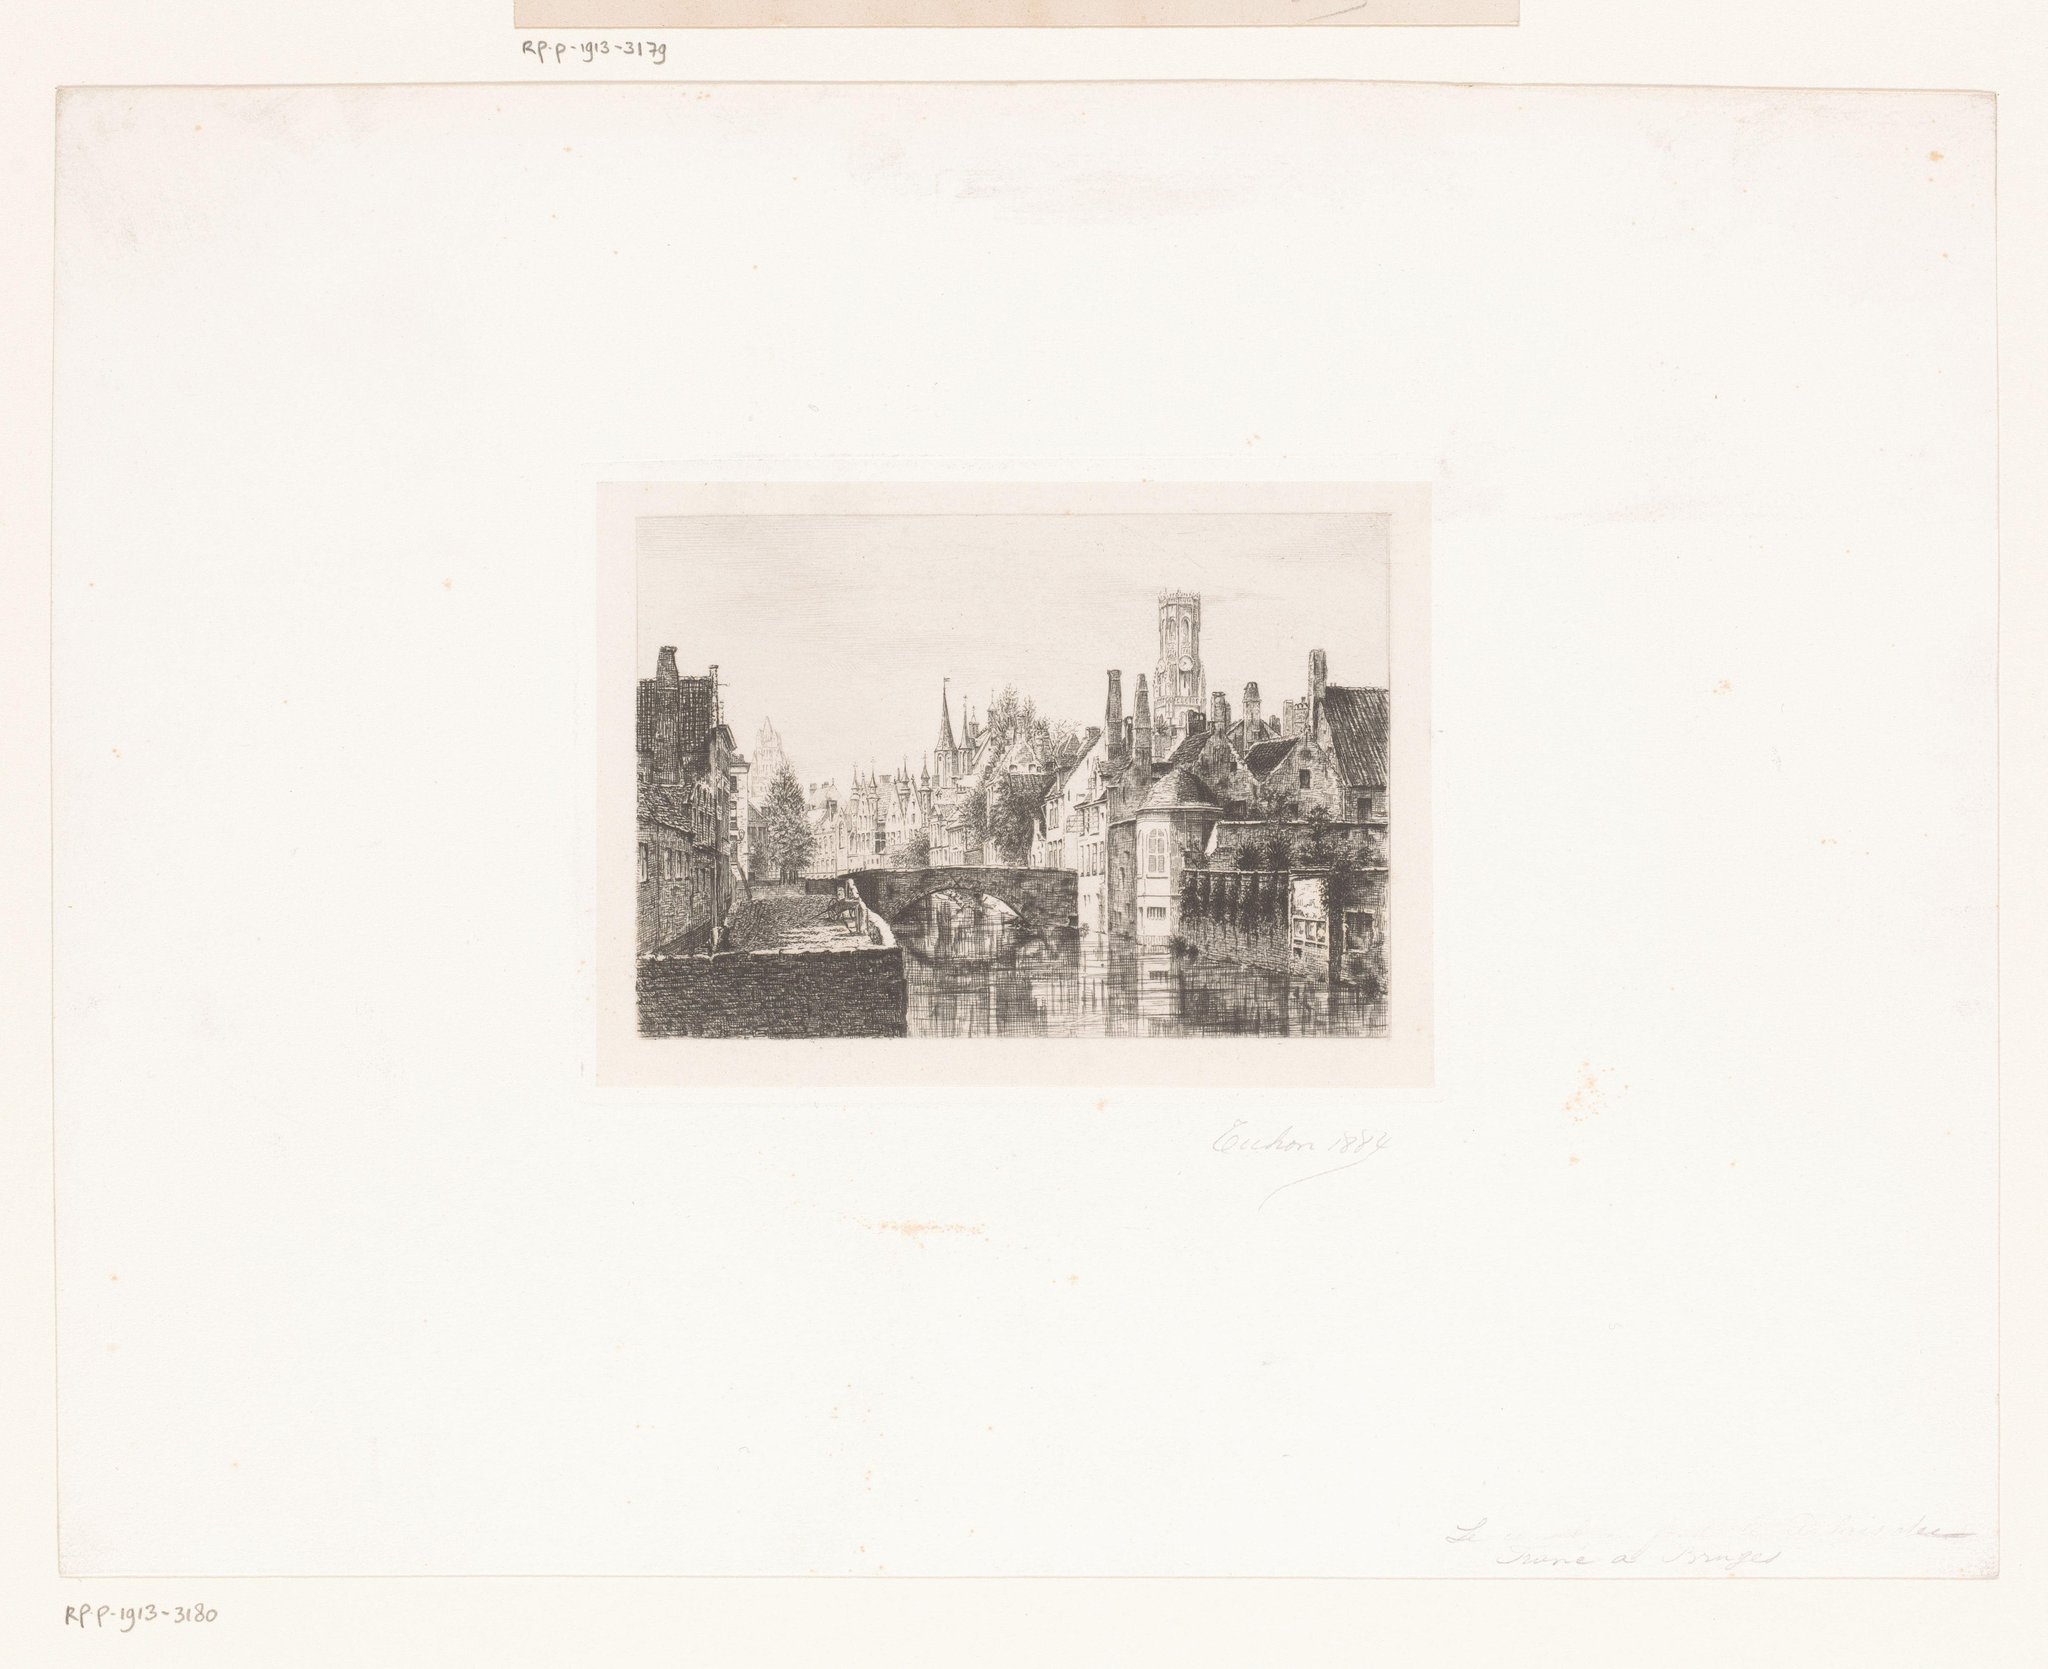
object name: print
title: Kanaal en het Vrije te Brugge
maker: charles tichon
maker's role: draughtsman, painter, print maker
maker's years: 1865-1924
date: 1884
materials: paper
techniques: etching, retroussage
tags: city-view in general; 'veduta', canals, waters (in city), bridge, bruges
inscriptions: collector's mark: Lugt 2228